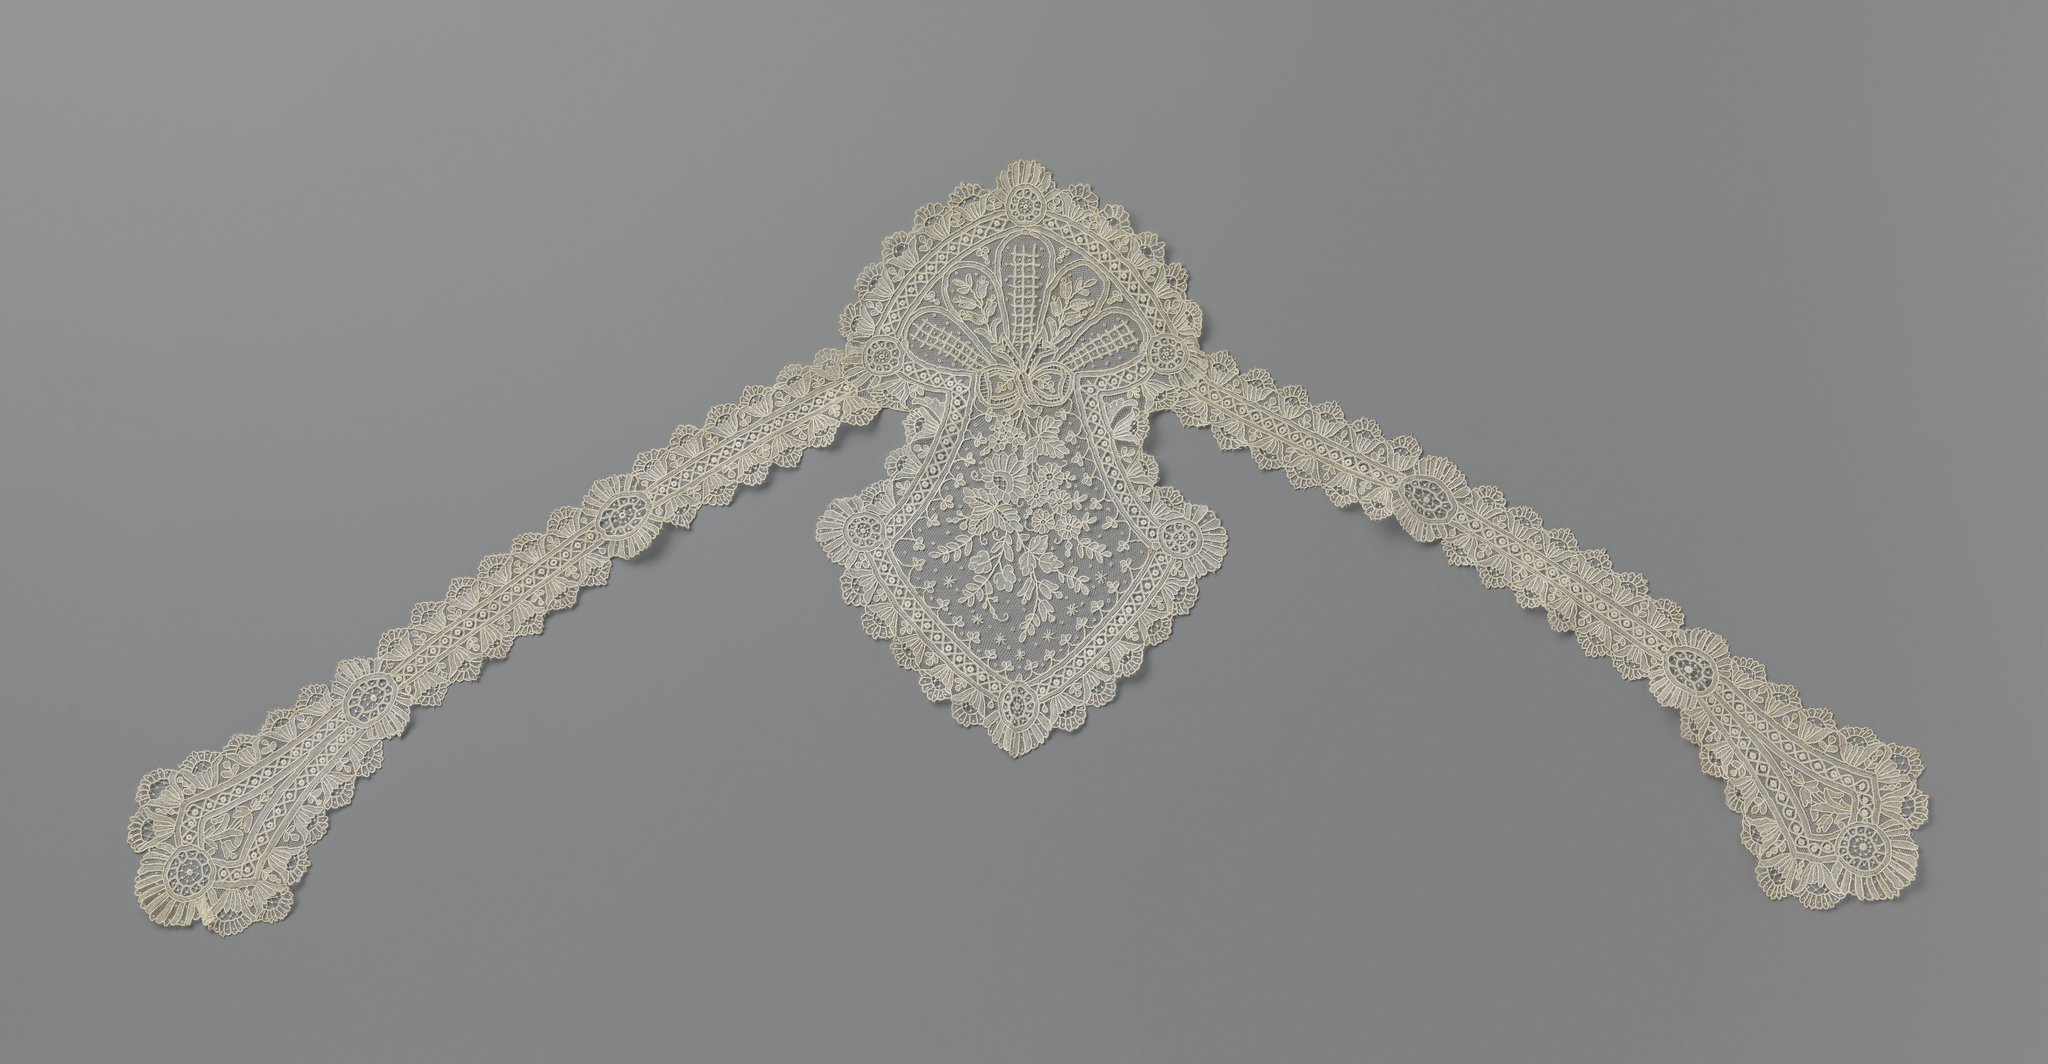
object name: fanchon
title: Fanchon van naaldkant met een strik met vijf lussen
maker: Anonymous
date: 1860-1880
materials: linen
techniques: needle lace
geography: brussels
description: Een tweezijdig geschulpt deel, dat op het kapsel ligt, vertoont een vijflussige strik, die een tuiltje van roos en margrietjes samenbindt. De zeer smalle, afhangende slippen eindigen in een verbrede punt. Een met ruiten gevuld lijstje wordt regelmatig onderbroken door een cirkel. Dicht aaneengesloten kelkbloemen vormen de buitenrand. Point de gaze de Bruxelles.